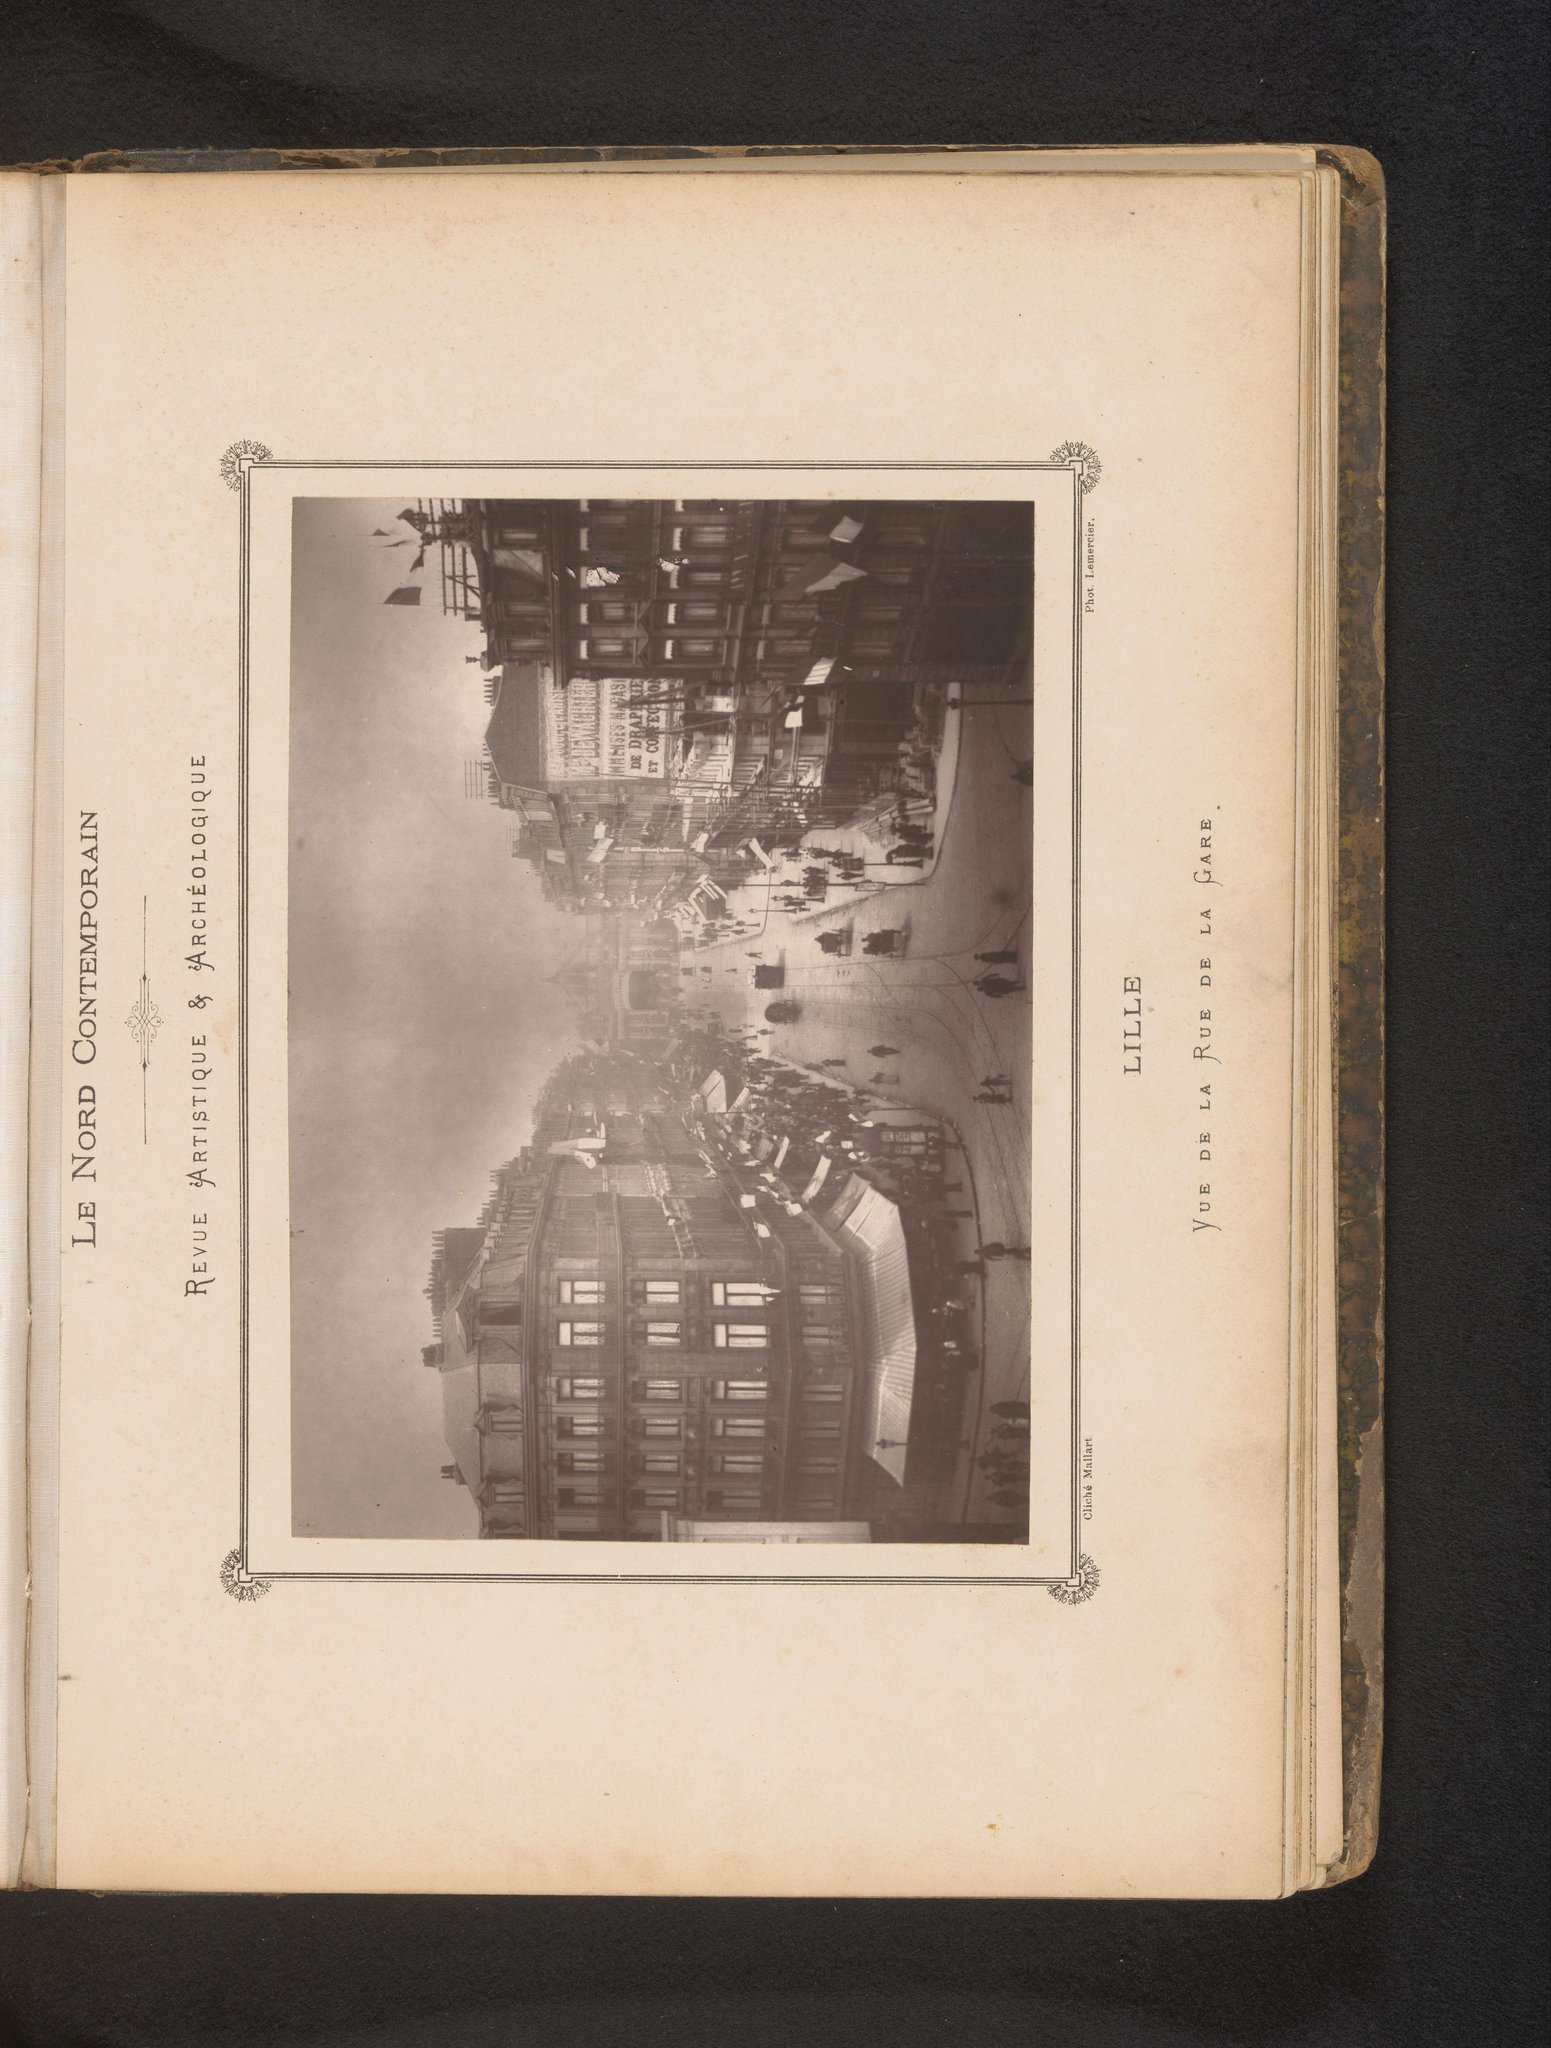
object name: photomechanical print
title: Lille, vue de la Rue de la Gare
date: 1878-1882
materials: paper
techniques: woodburytype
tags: city-view in general; 'veduta', street, lille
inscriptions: inscription: ‘Le Nord Contemporain/ Revue Artistique & Archéologique’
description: Prent op derde ongenummerde pagina na pagina 240.